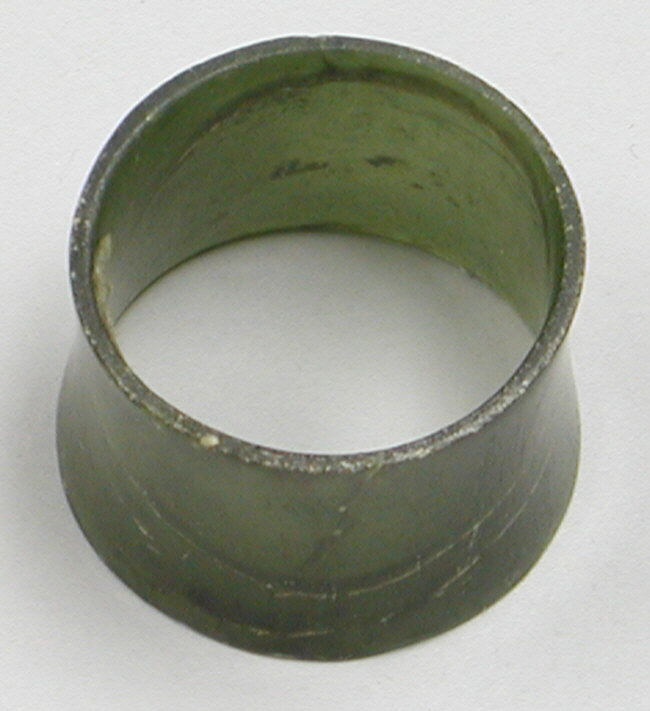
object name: ear spool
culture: mexican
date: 1501-1600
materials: stone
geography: mexico